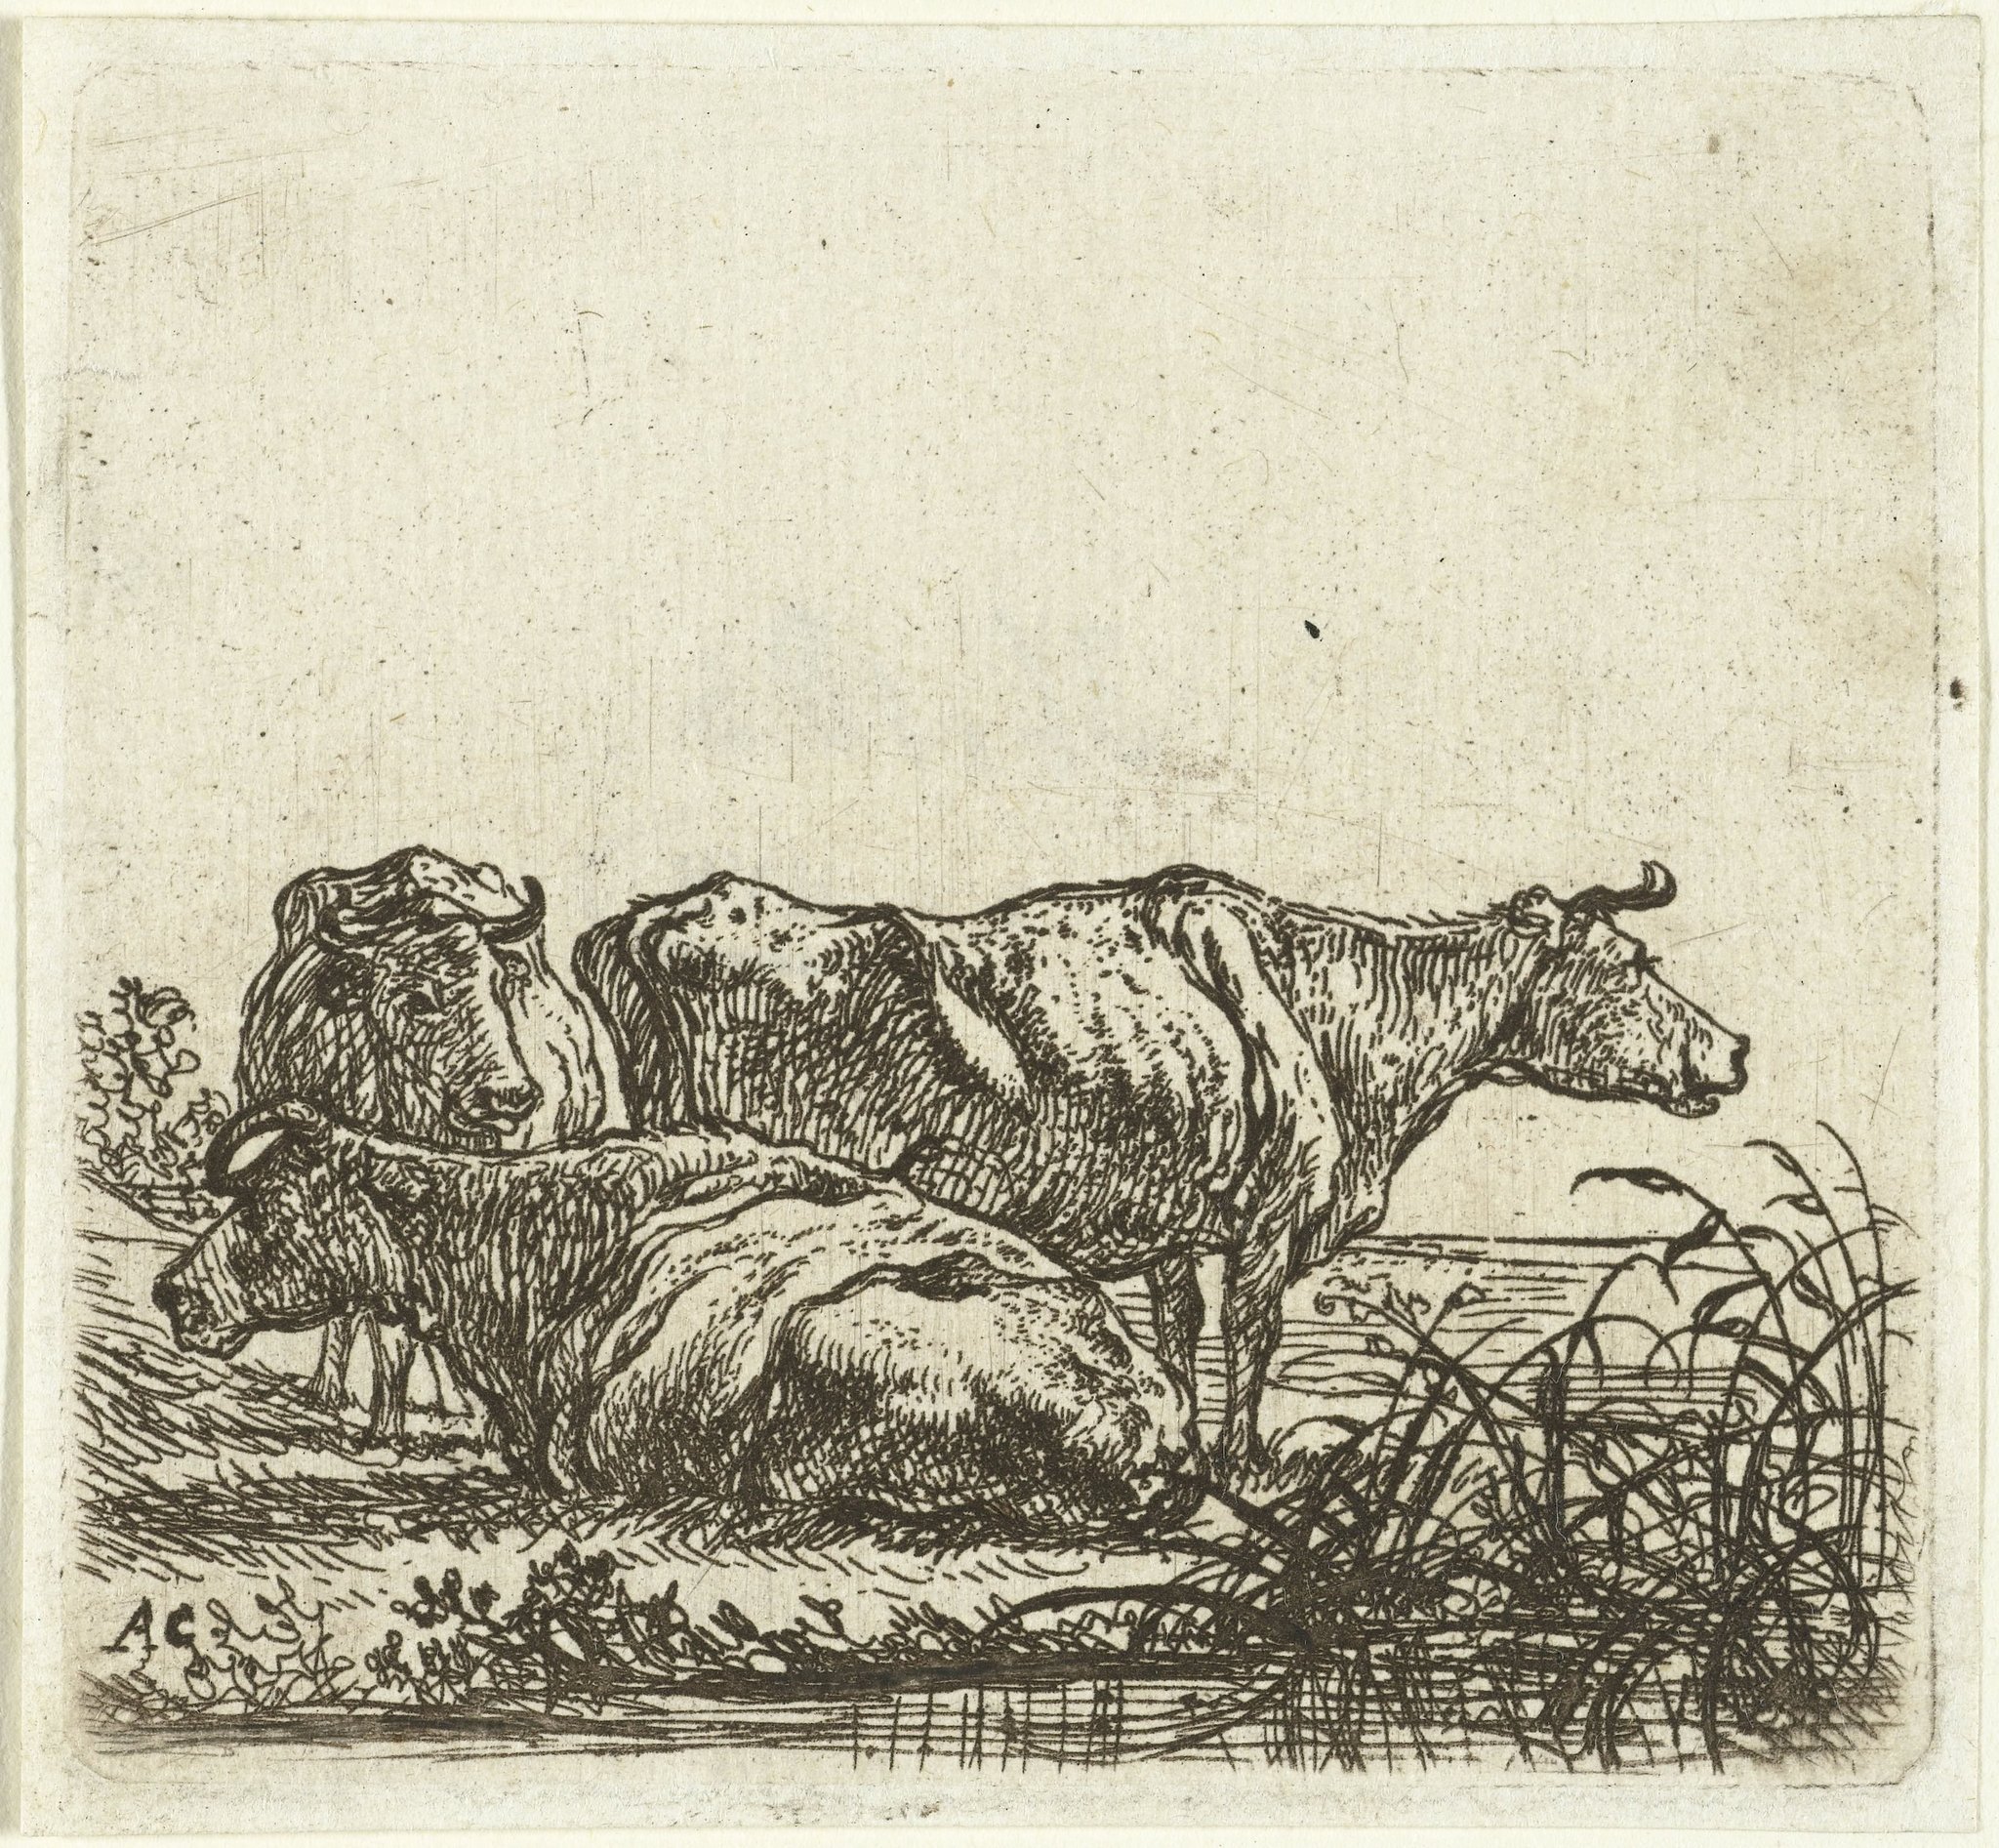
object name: print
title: Koeien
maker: aelbert cuyp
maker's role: draughtsman, painter, print maker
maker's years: 1620-1691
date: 1630-1691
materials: paper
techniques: etching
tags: cow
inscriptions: collector's mark: Lugt 2228, collector's mark: Lugt 2760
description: Prent uit serie van zes prenten met koeien.